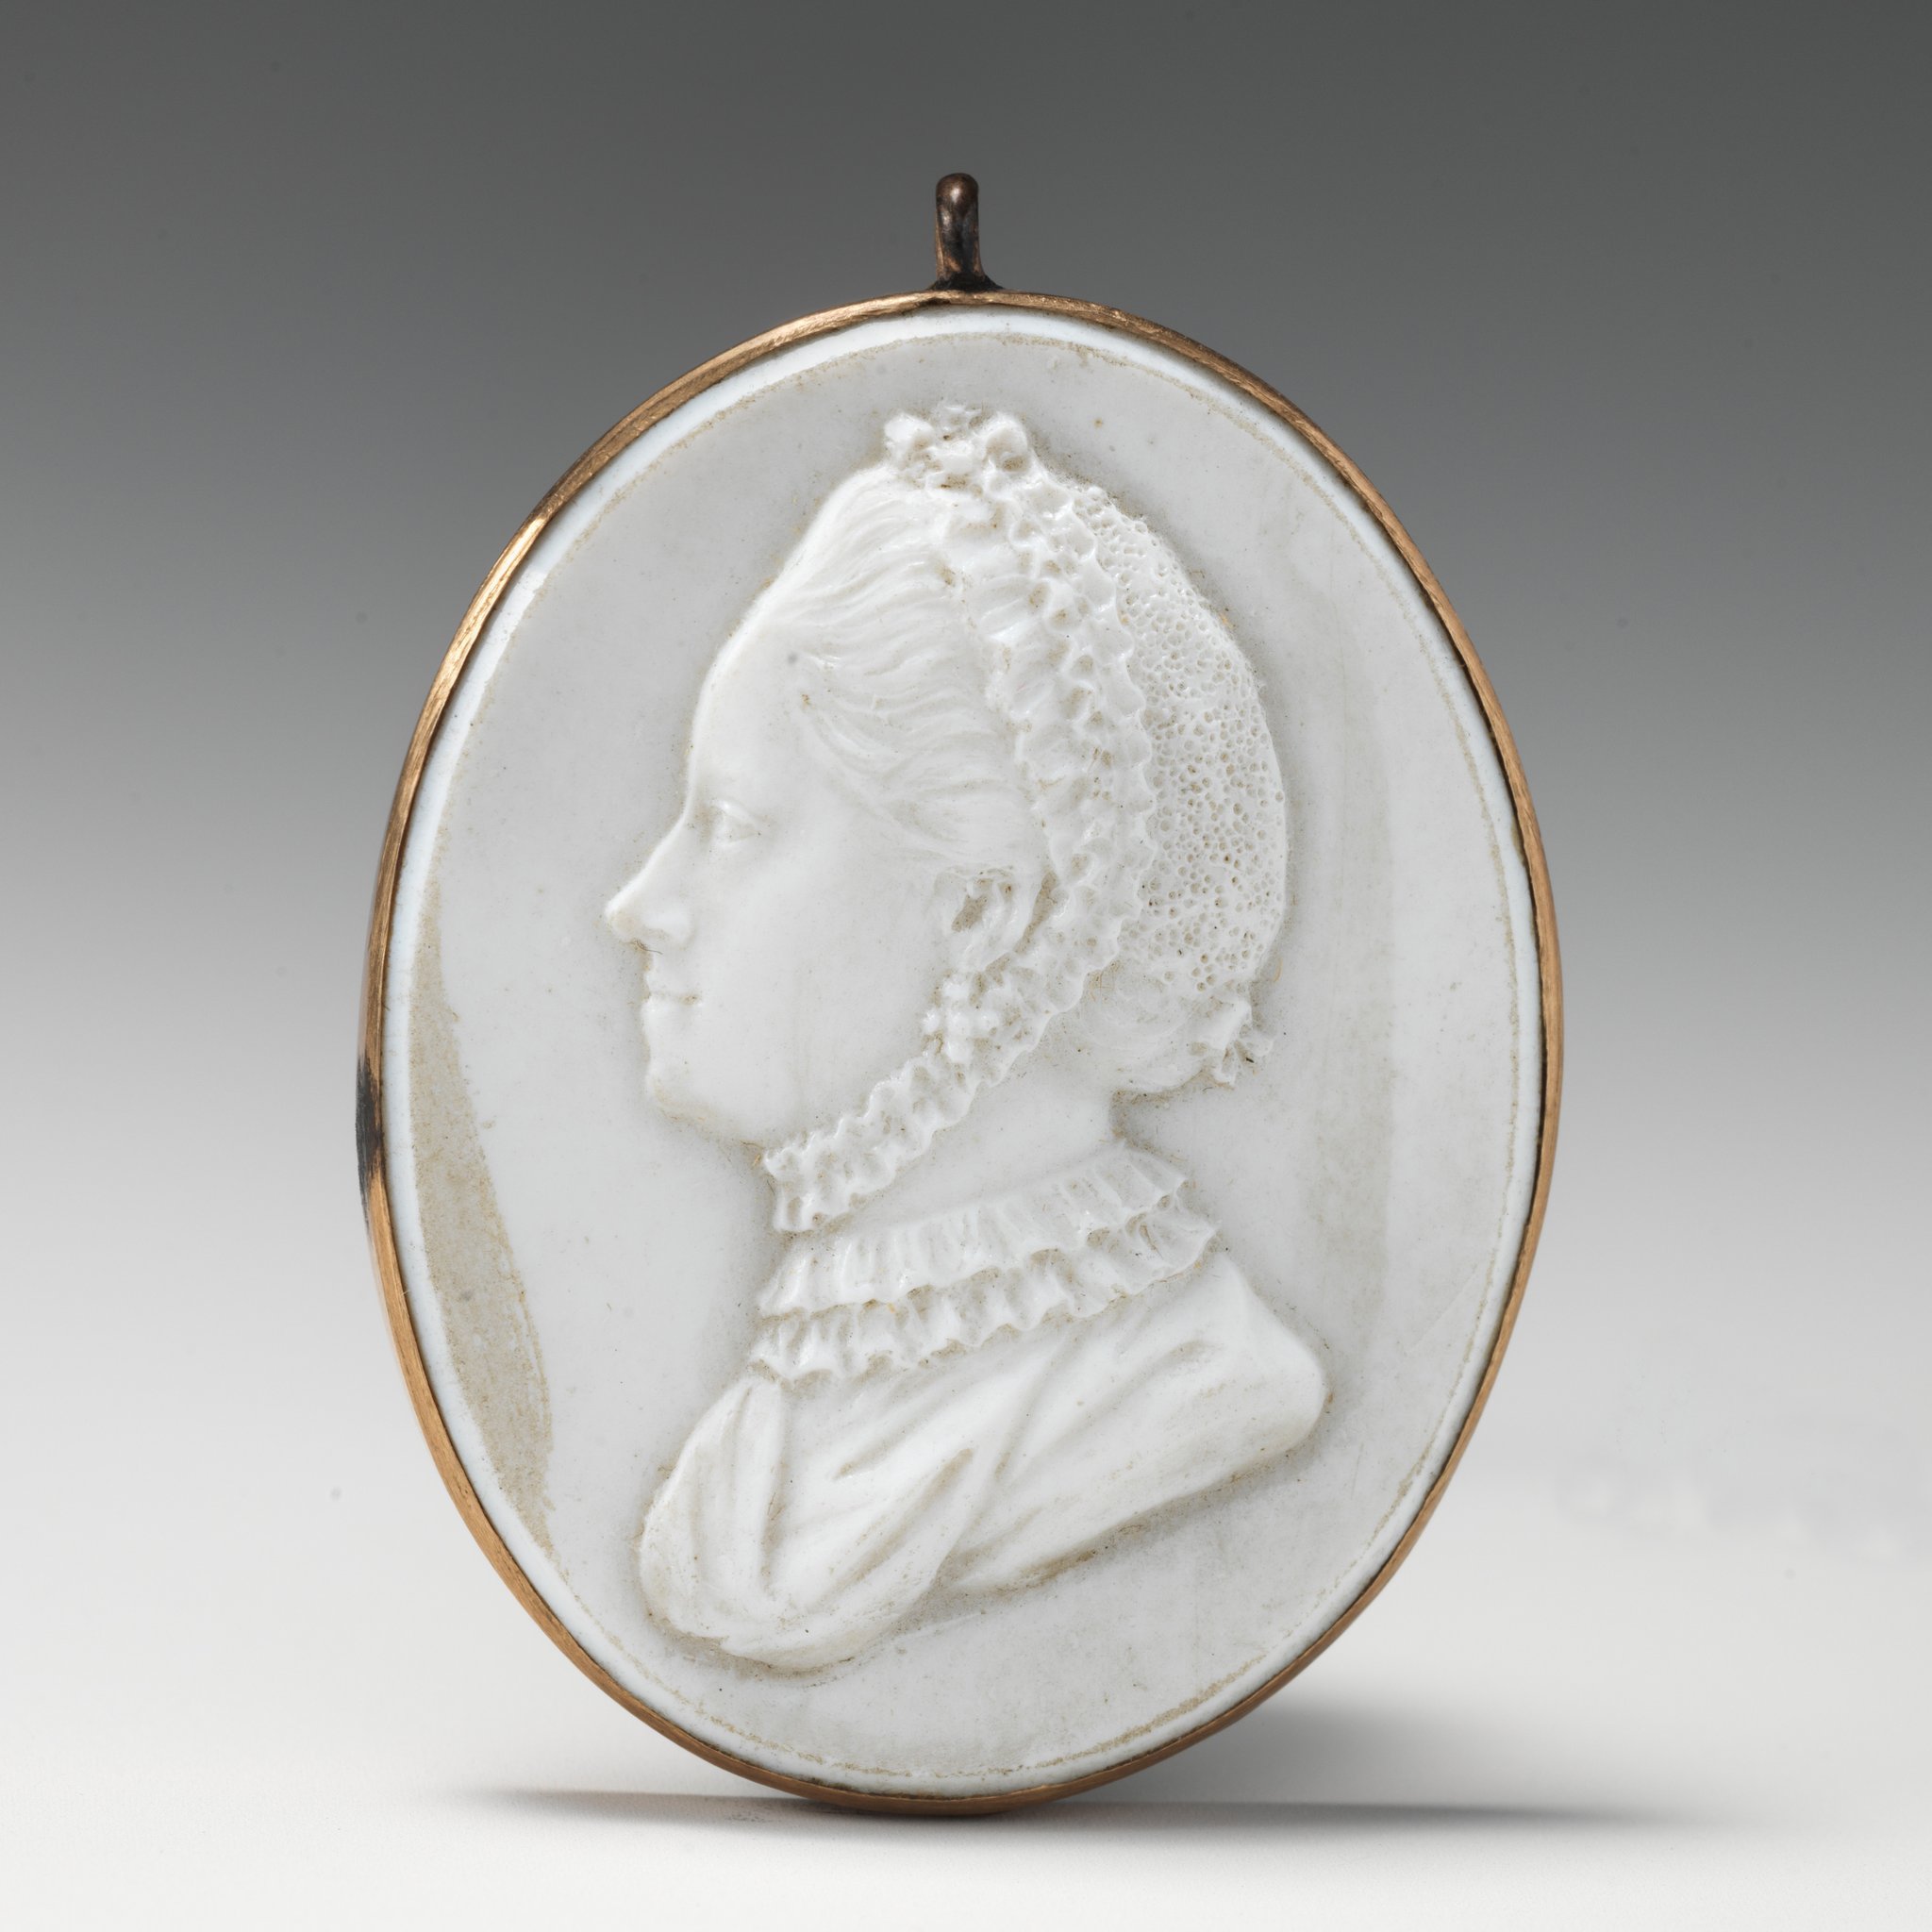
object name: medallion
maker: james tassie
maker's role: artist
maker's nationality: british, scottish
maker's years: 1735-1799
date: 1701-1800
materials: glass, paste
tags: profiles,women